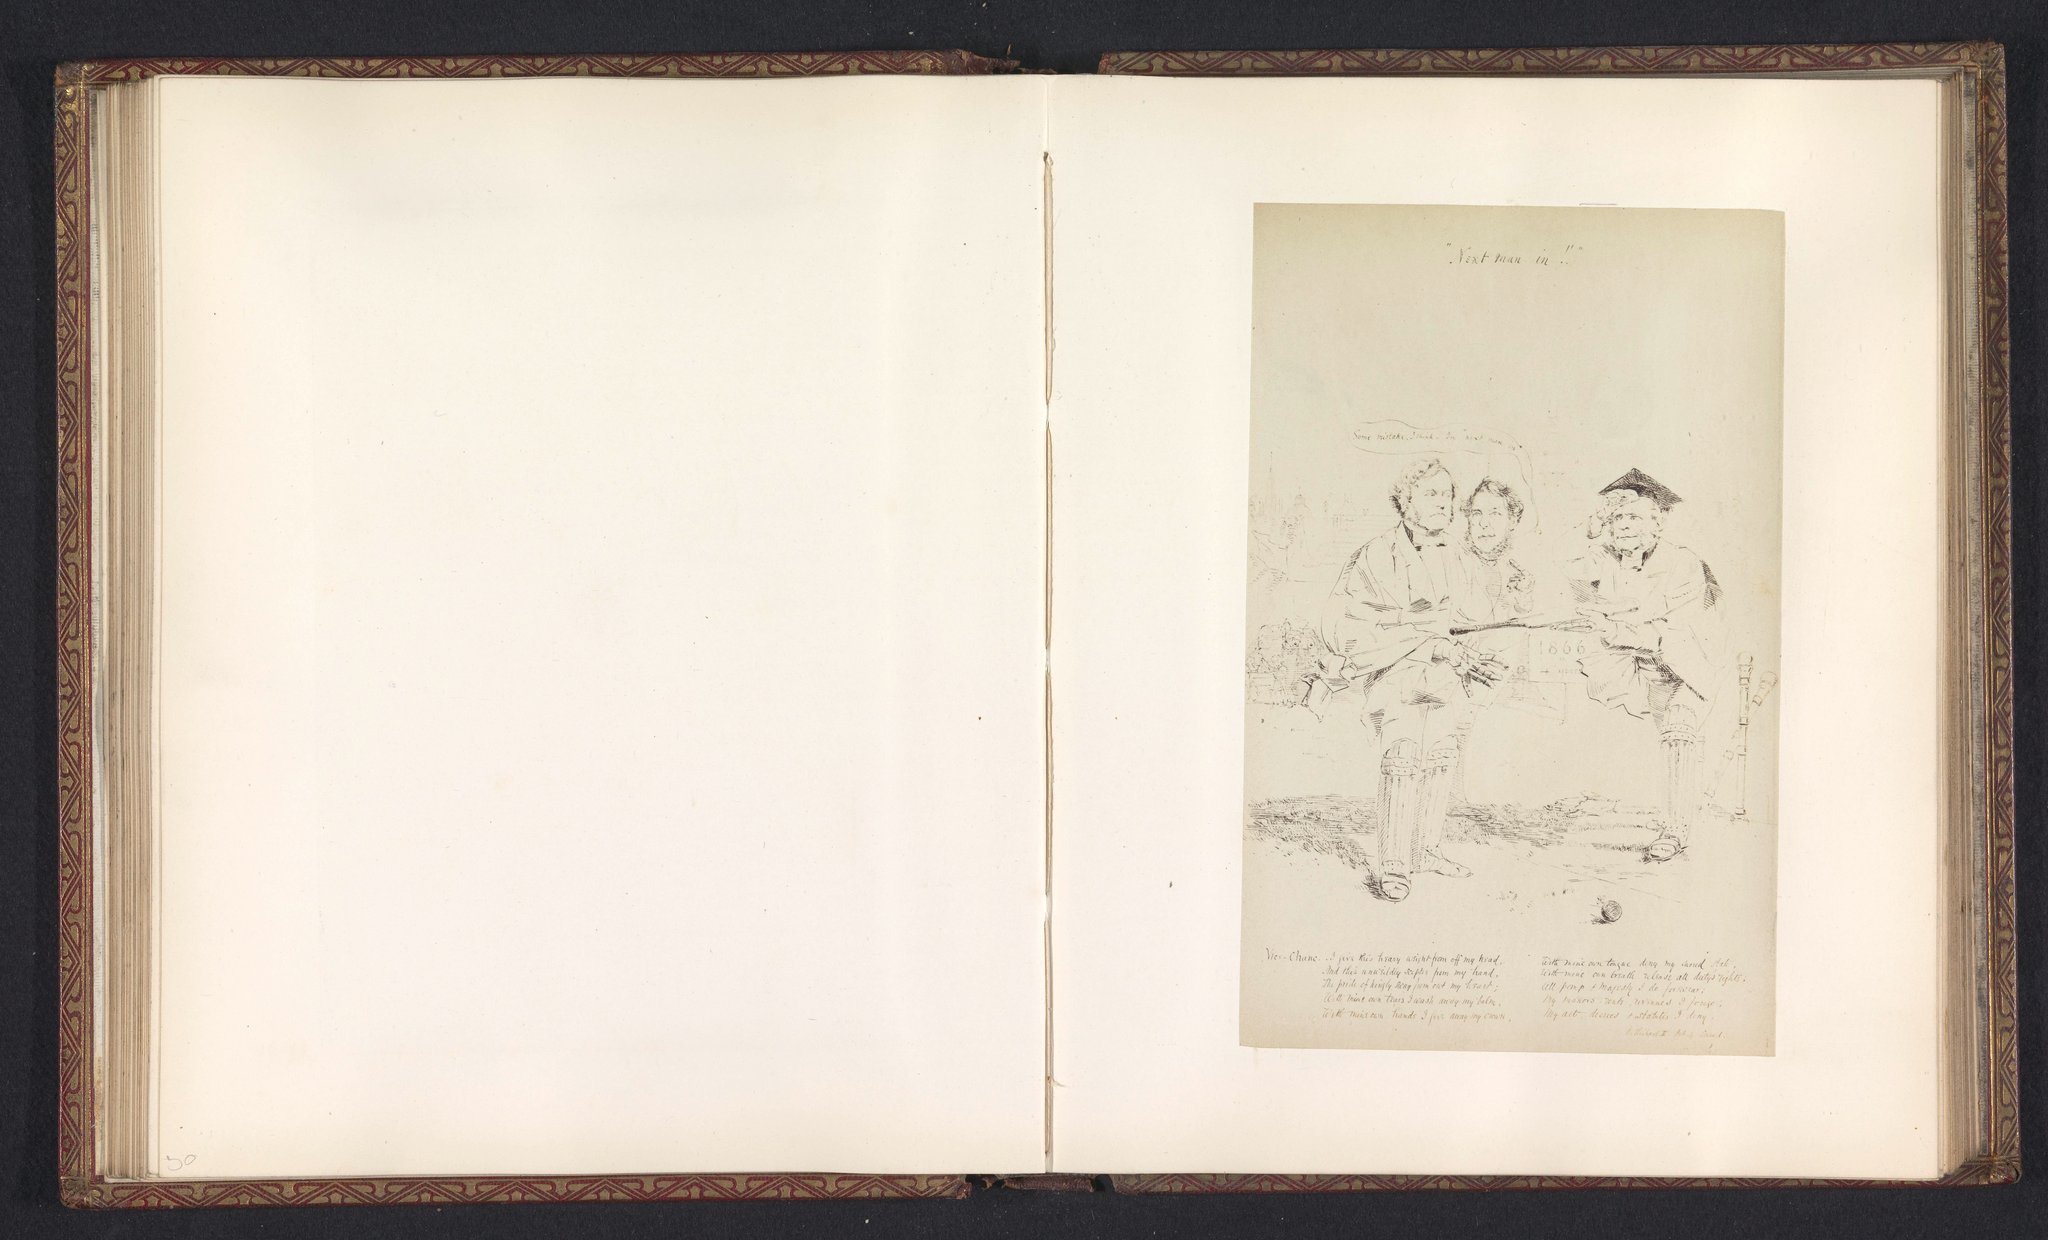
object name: reproduction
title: Fotoreproductie van een tekening, voorstellende dr. Lightfoot overhandigt een cricketbat aan dr. Leighton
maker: Anonymous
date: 1855-1866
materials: photographic support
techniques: albumen print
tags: cricket (ball game), caricatures (human types), professor, student life